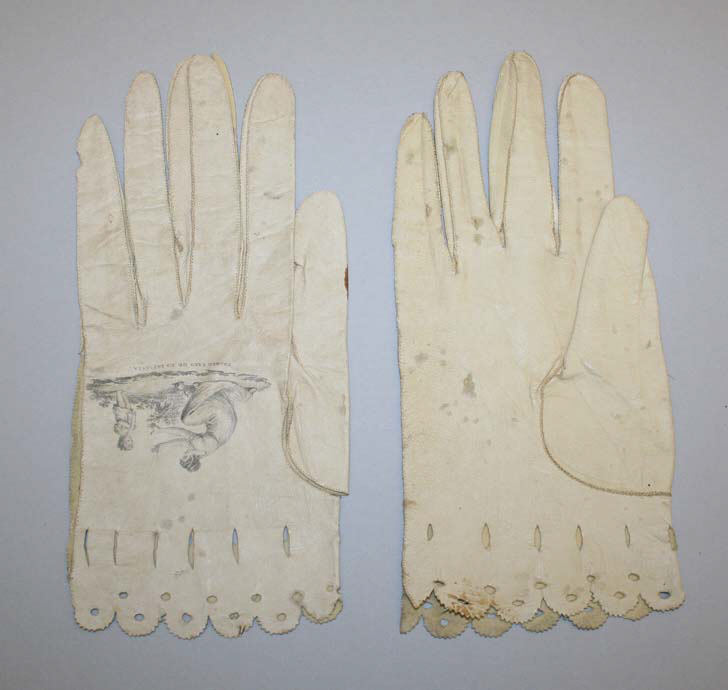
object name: glove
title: Gloves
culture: spanish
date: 1801-1833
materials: leather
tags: children,women